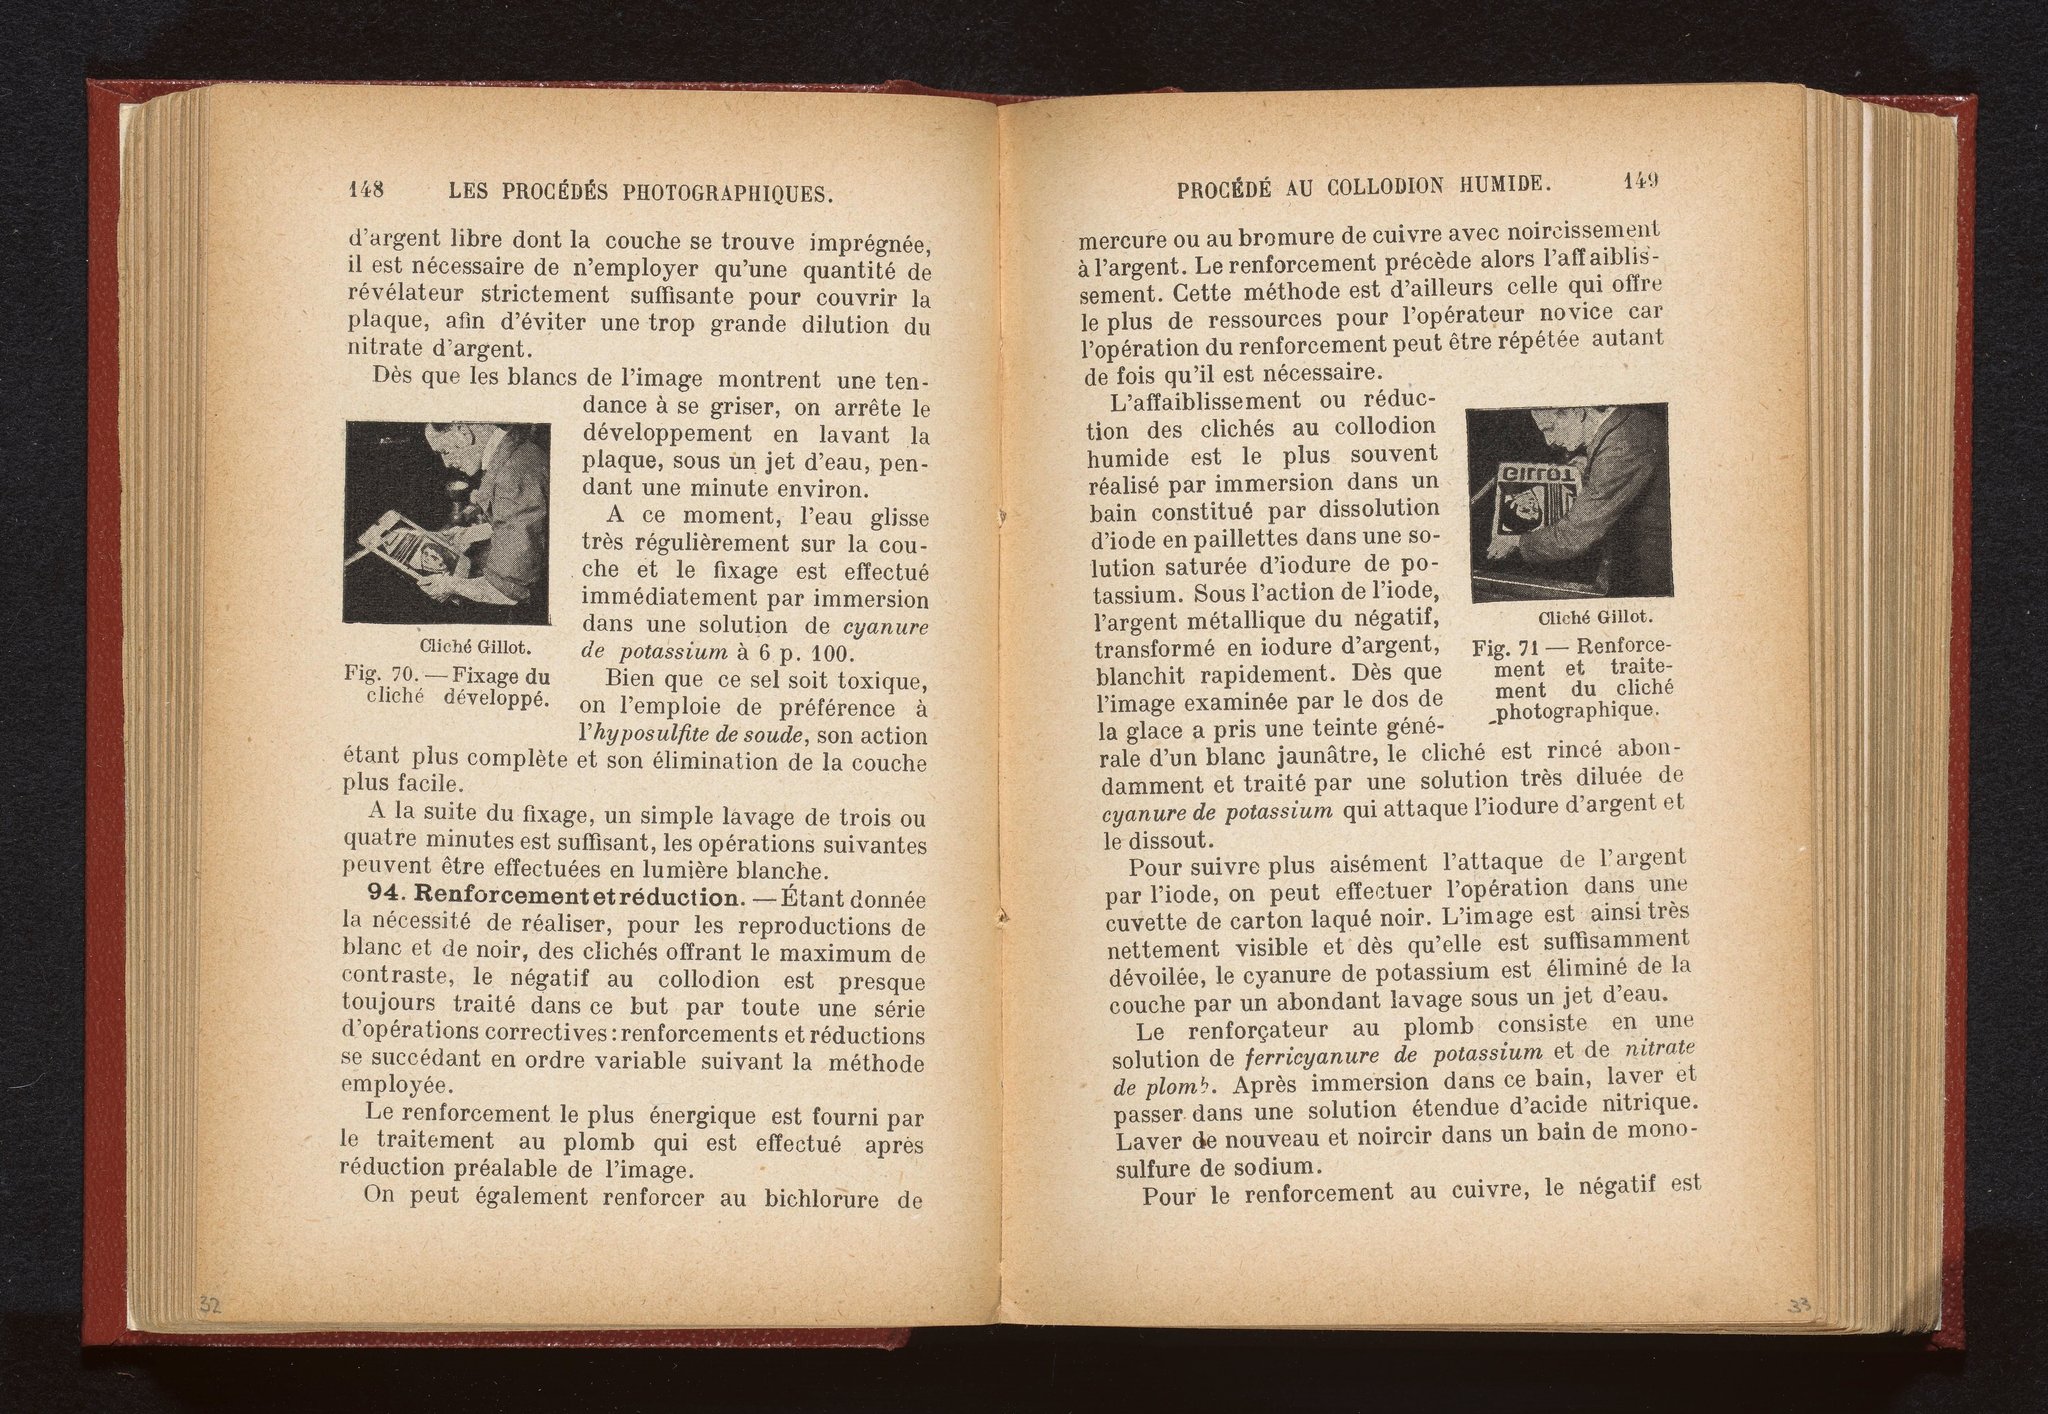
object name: photomechanical print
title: Man die een ontwikkelde fotografische opname fixeert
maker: Anonymous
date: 1922-1932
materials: paper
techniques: autotype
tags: photographic apparatus, developing ~ film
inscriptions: number: ‘Fig. 70.’